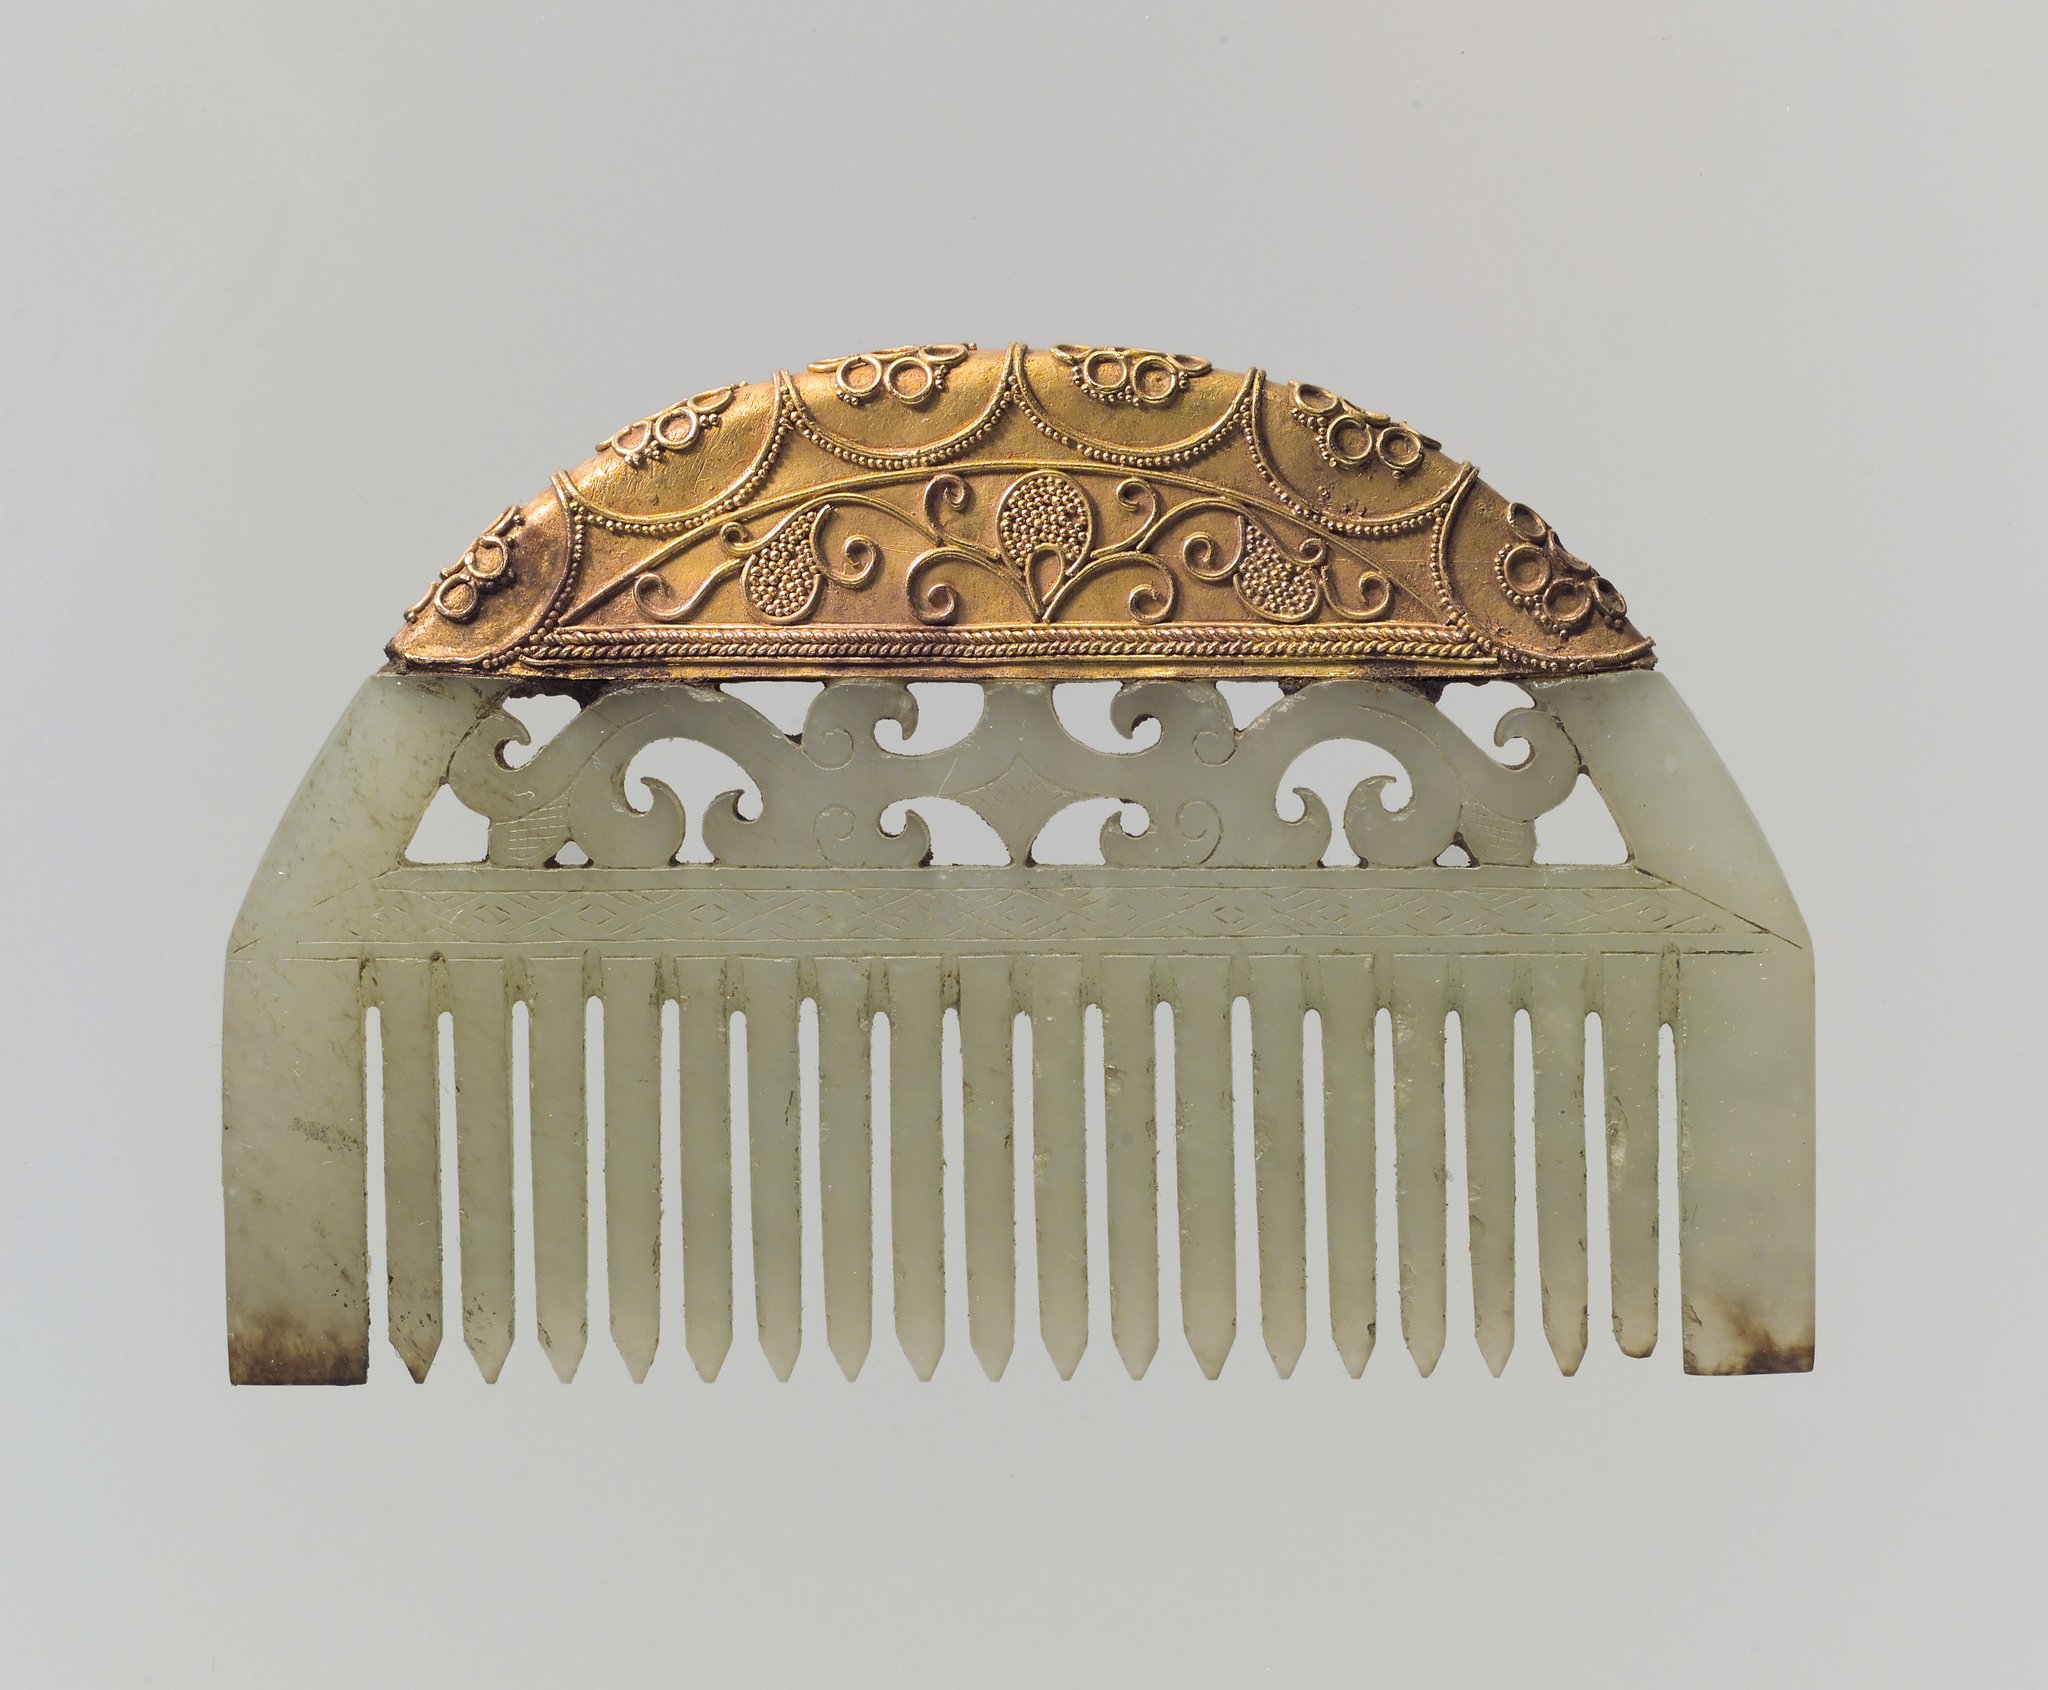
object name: comb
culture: chinese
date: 25-220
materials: gold, jade